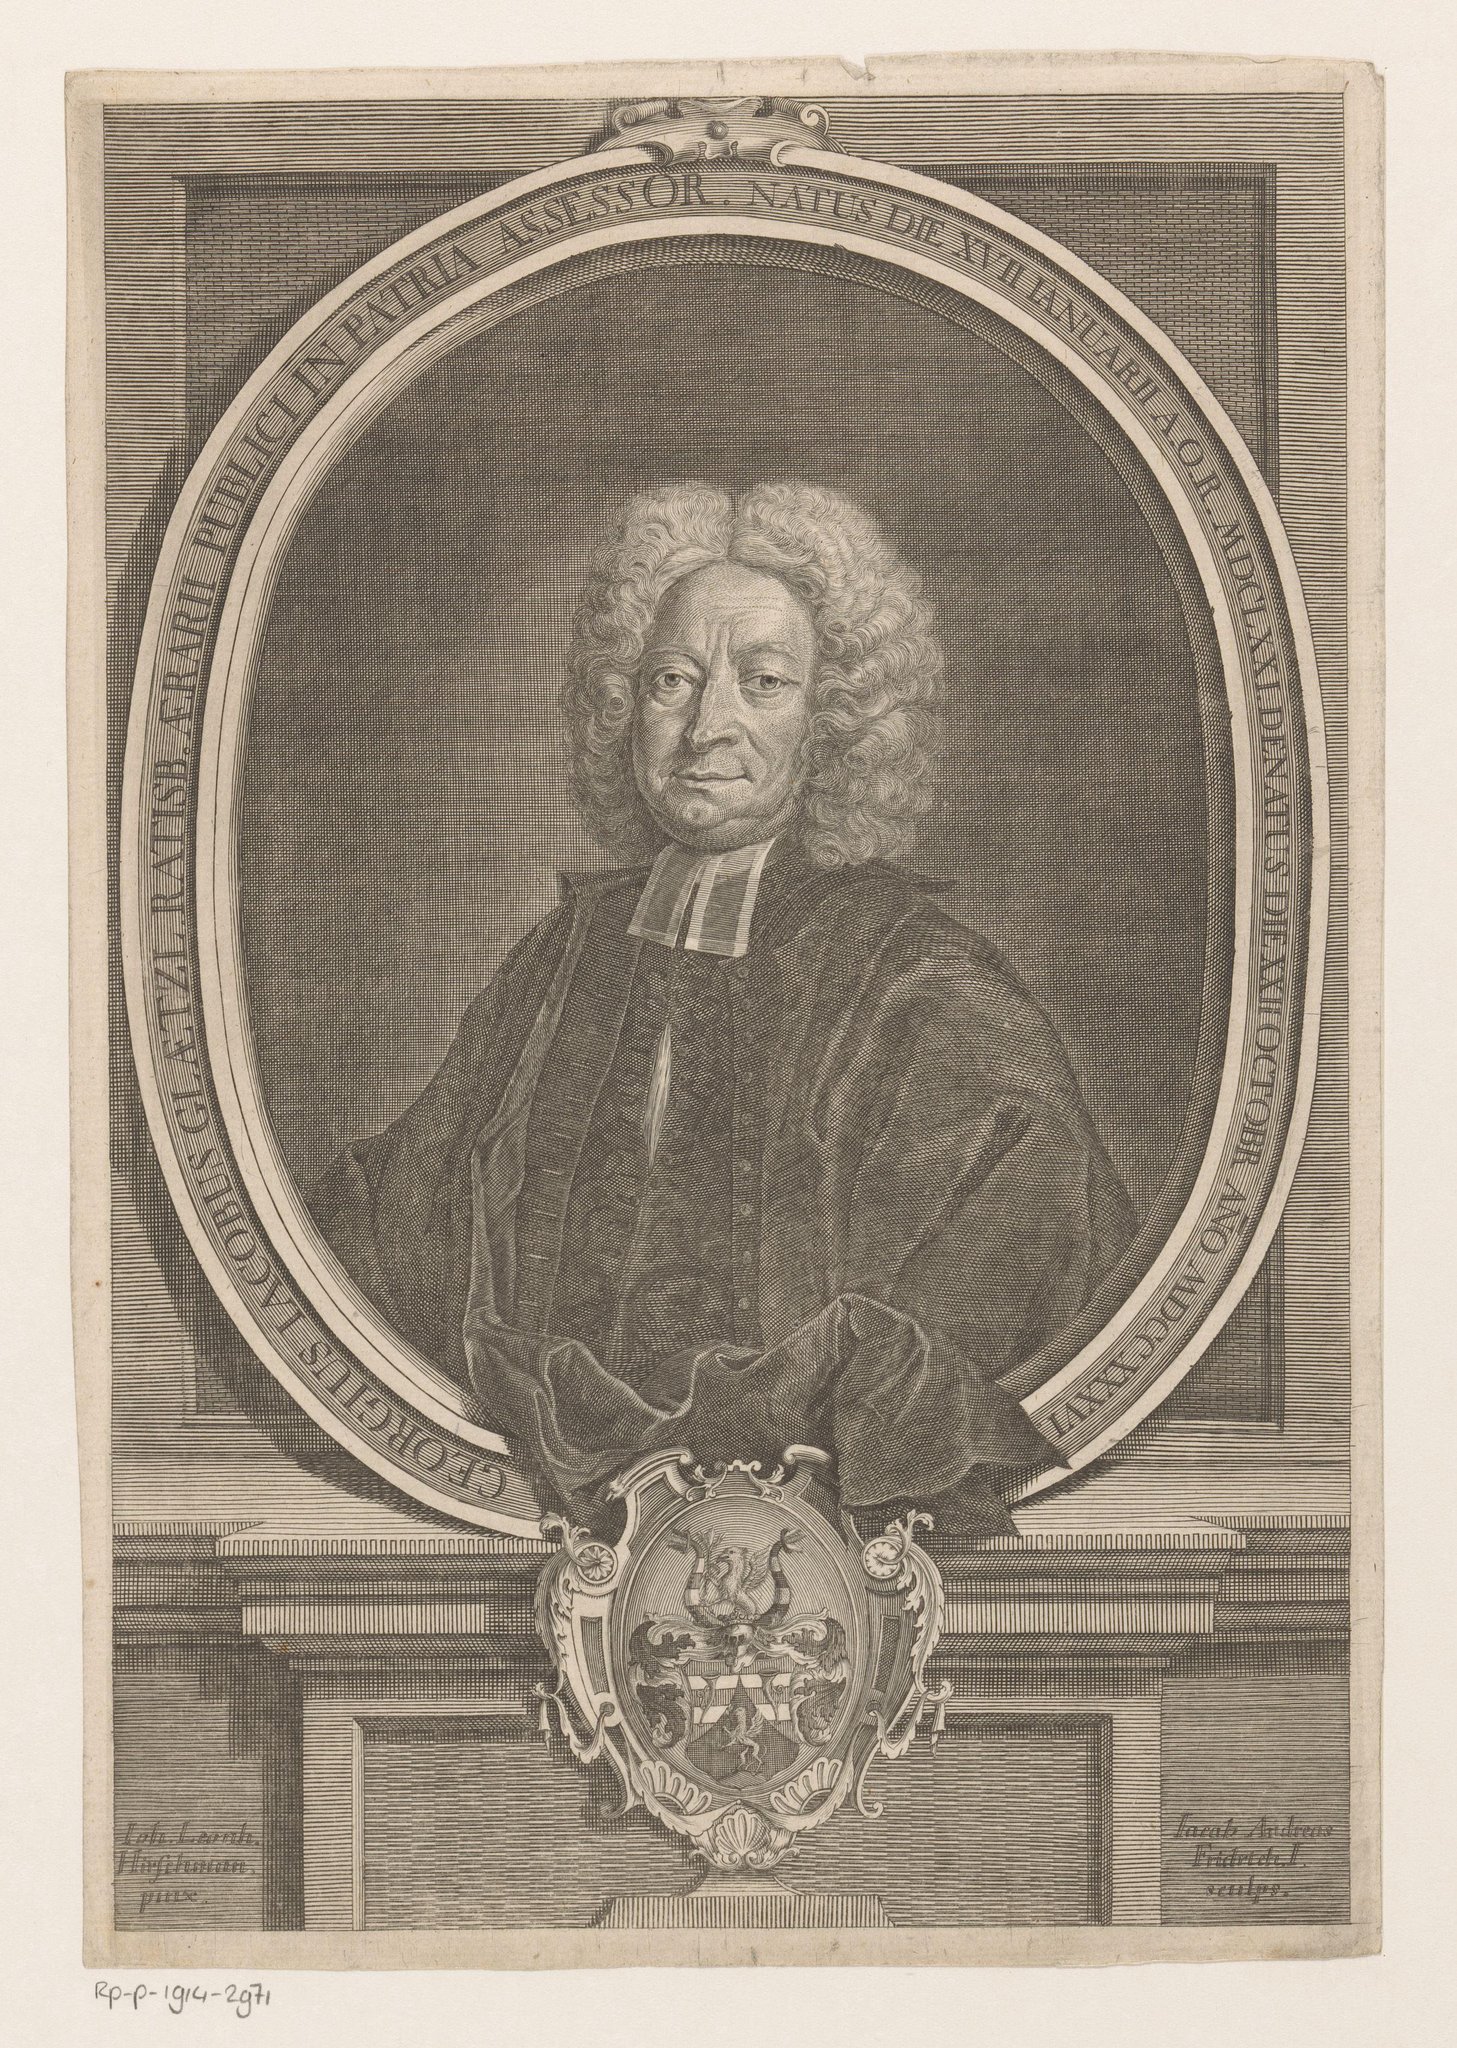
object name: print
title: Portret van Georg Jakob Glaetzl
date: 1736-1751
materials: paper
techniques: engraving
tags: ornament ~ medallion, historical persons, armorial bearing, heraldry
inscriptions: collector's mark: Lugt 2228